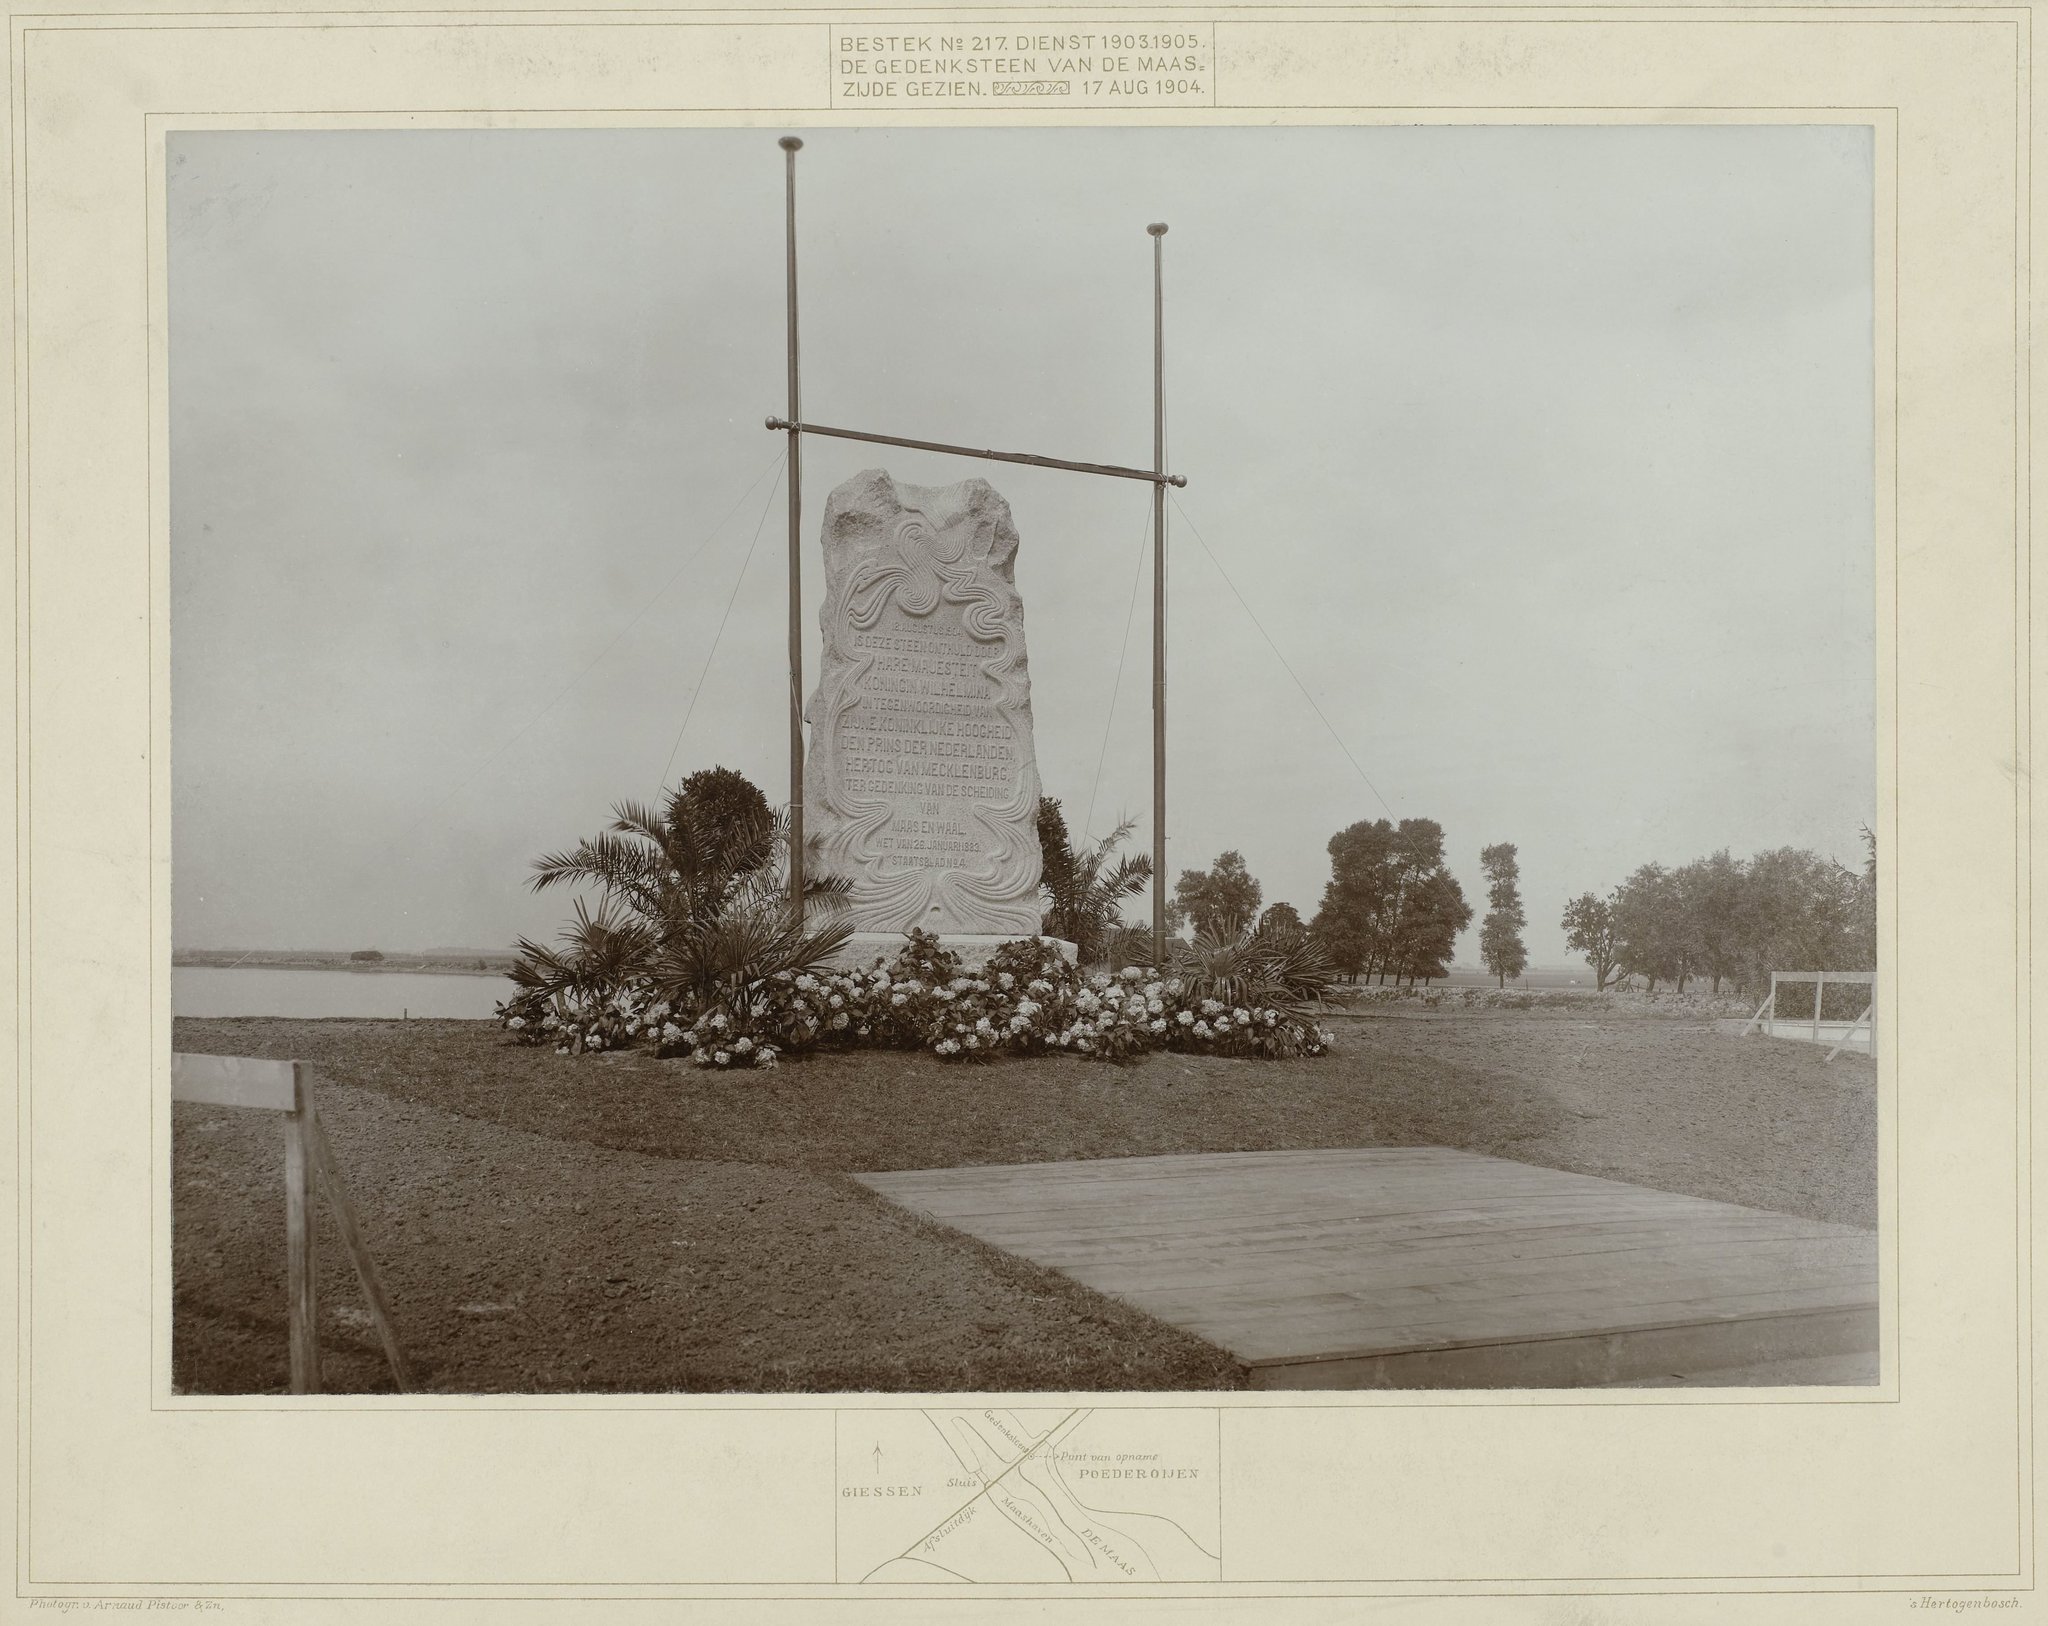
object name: photograph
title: Bestek nr. 217, dienst 1903, 1905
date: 1904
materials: cardboard, paper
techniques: photography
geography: den bosch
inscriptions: date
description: Foto op karton van waterbouwkundige werken (ten behoeve van de scheiding tussen maas en waal). Tekst boven de foto, onder de foto een situatiekaartje. Opschrift; b.: 'De gedenksteen van de maaszijde gezien 17 aug. 1904. Gesigneerd en gedateerd.